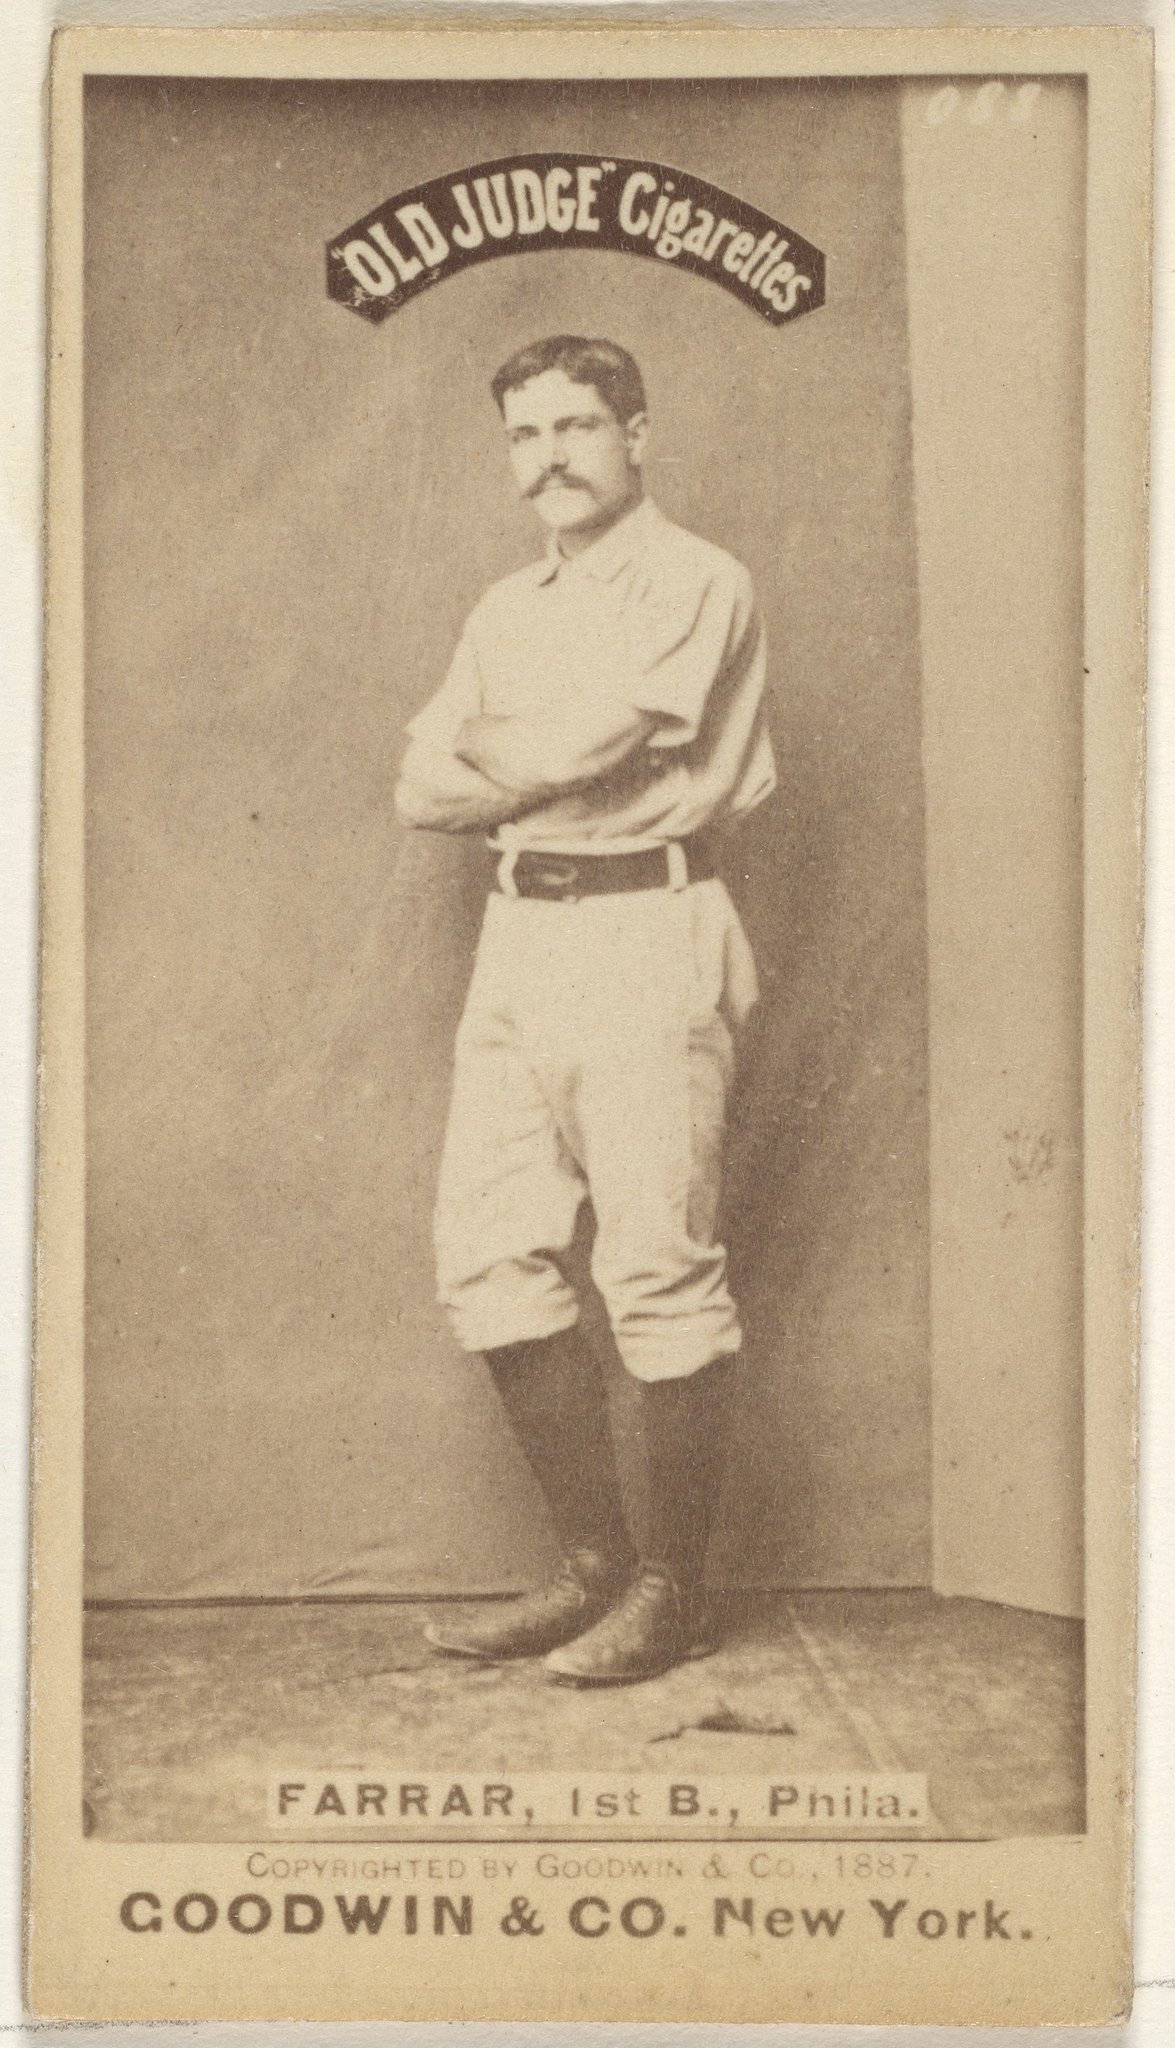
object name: baseball card, photograph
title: Sidney Douglas Farrar, 1st Base, Philadelphia, from the Old Judge series (N172) for Old Judge Cigarettes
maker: goodwin & company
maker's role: publisher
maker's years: 1850-1950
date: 1887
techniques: albumen silver print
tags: men,portraits,baseball,athletes